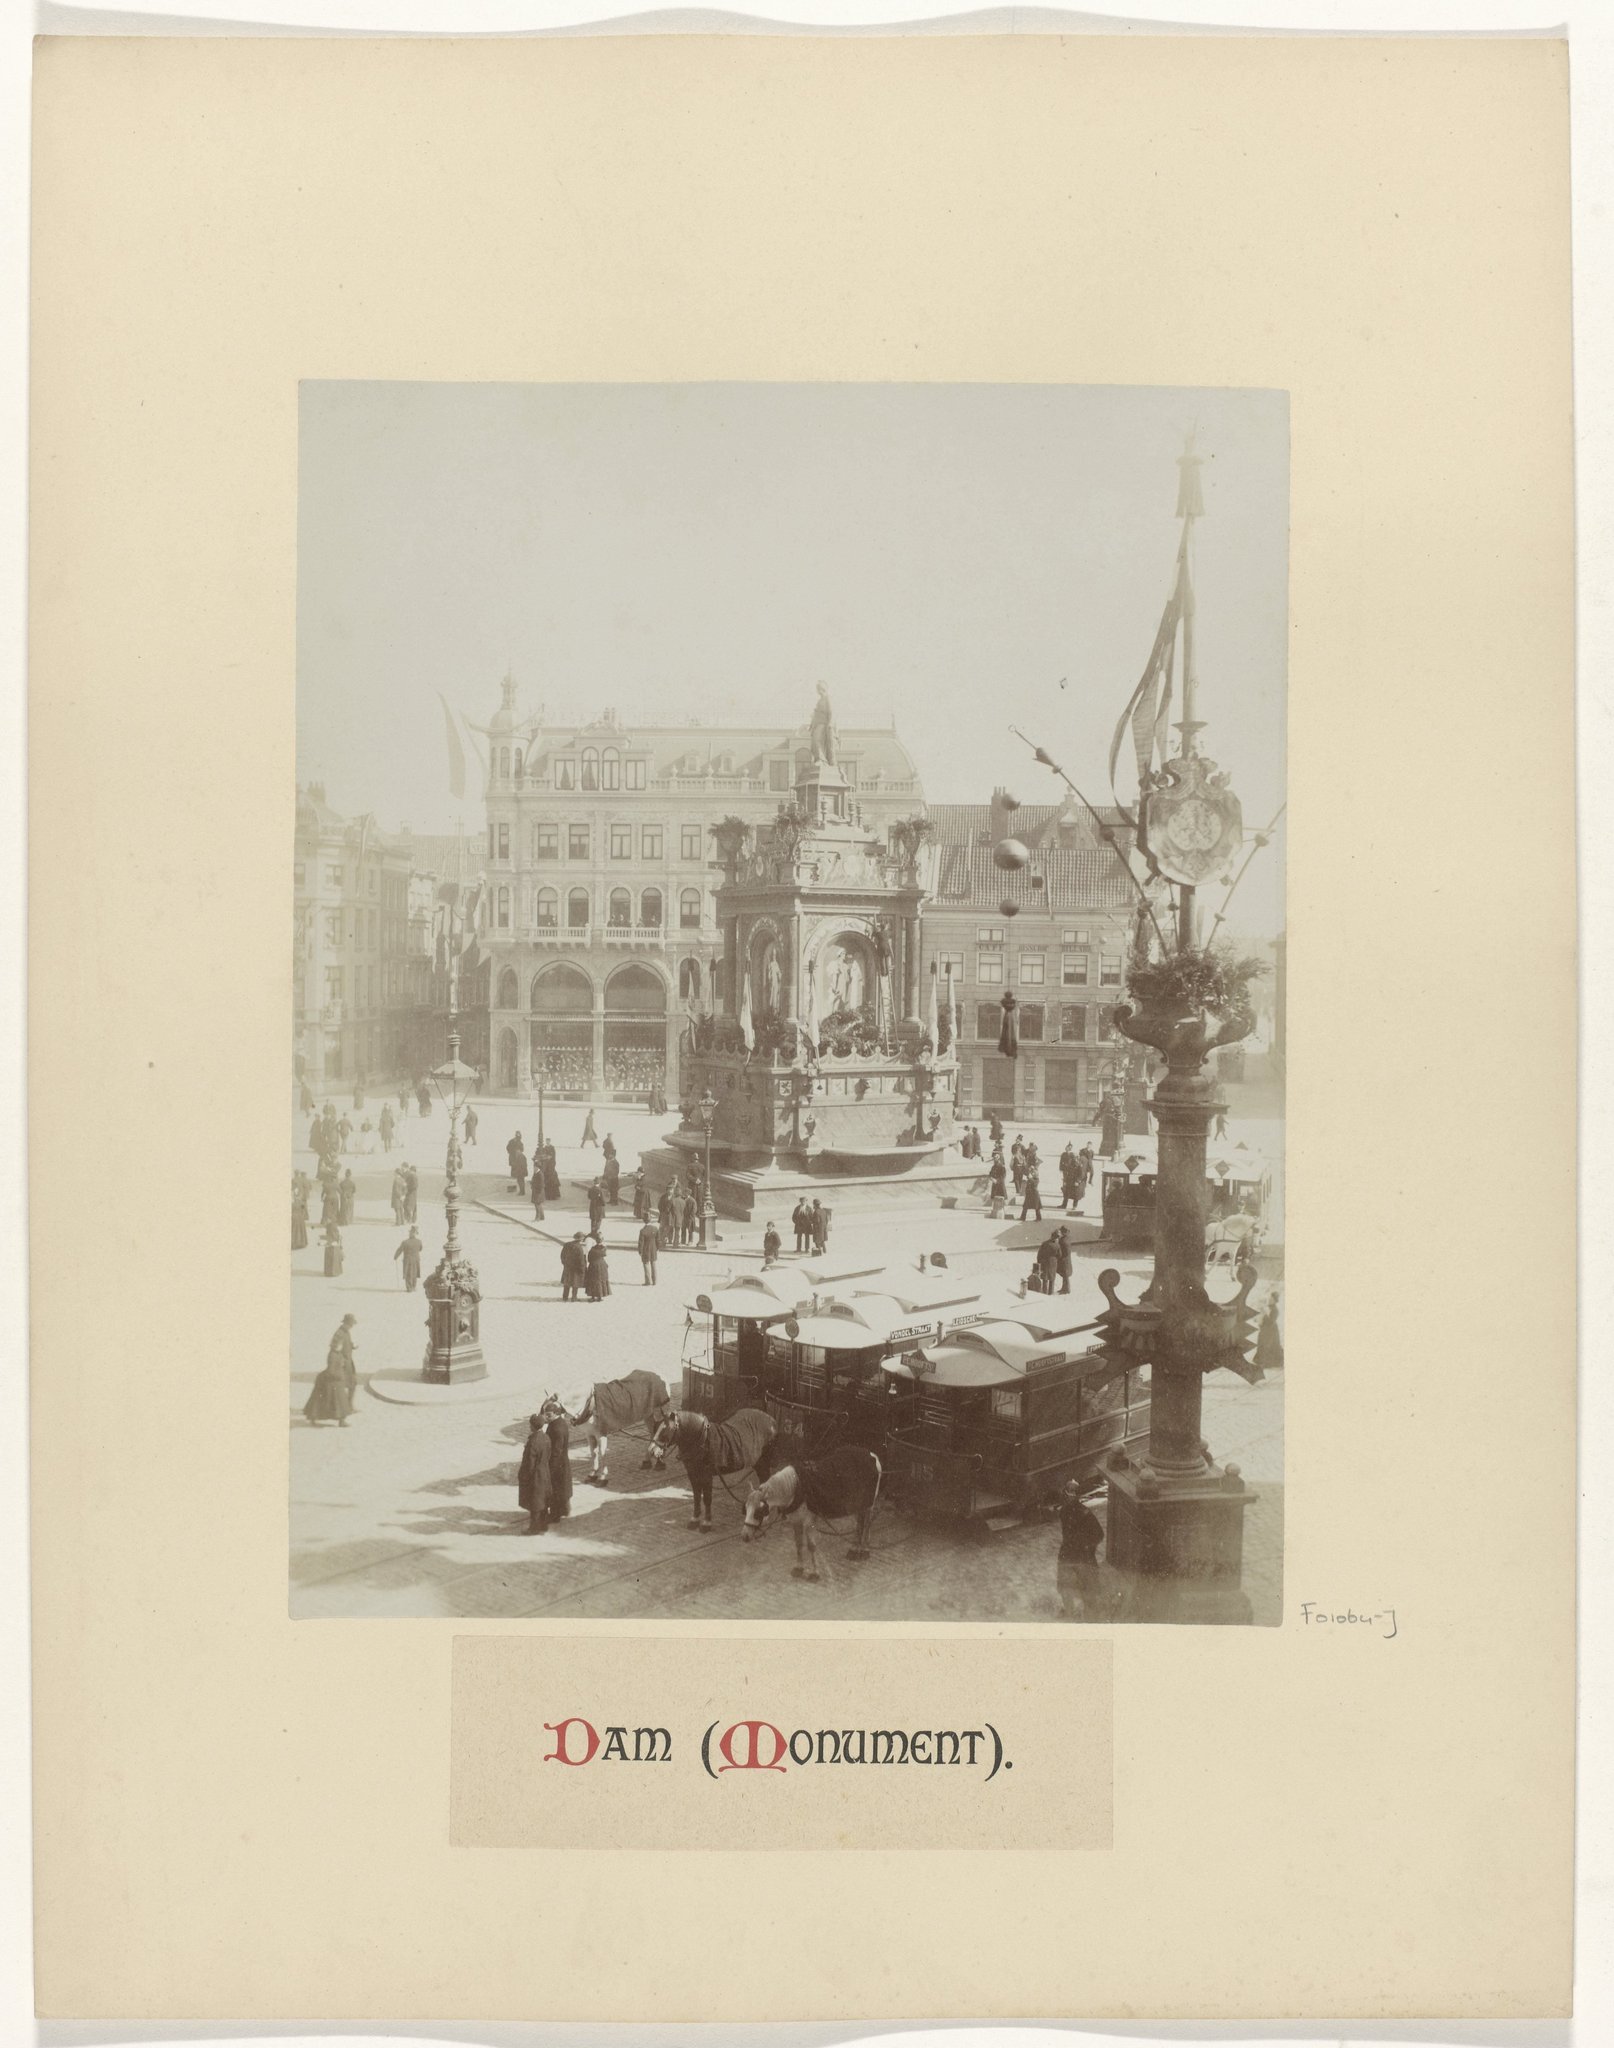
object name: photograph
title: Gezicht op het monument op de Dam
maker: henri de louw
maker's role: fotograaf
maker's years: 1851-1944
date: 1887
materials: cardboard, paper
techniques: albumen print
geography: amsterdam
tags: square, place, circus, etc., public festivities on the occasion of royal events, monument, statue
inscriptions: inscription: ‘Dam (Monument)’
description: Deze foto maakt deel uit van een omslag met twaalf foto's.